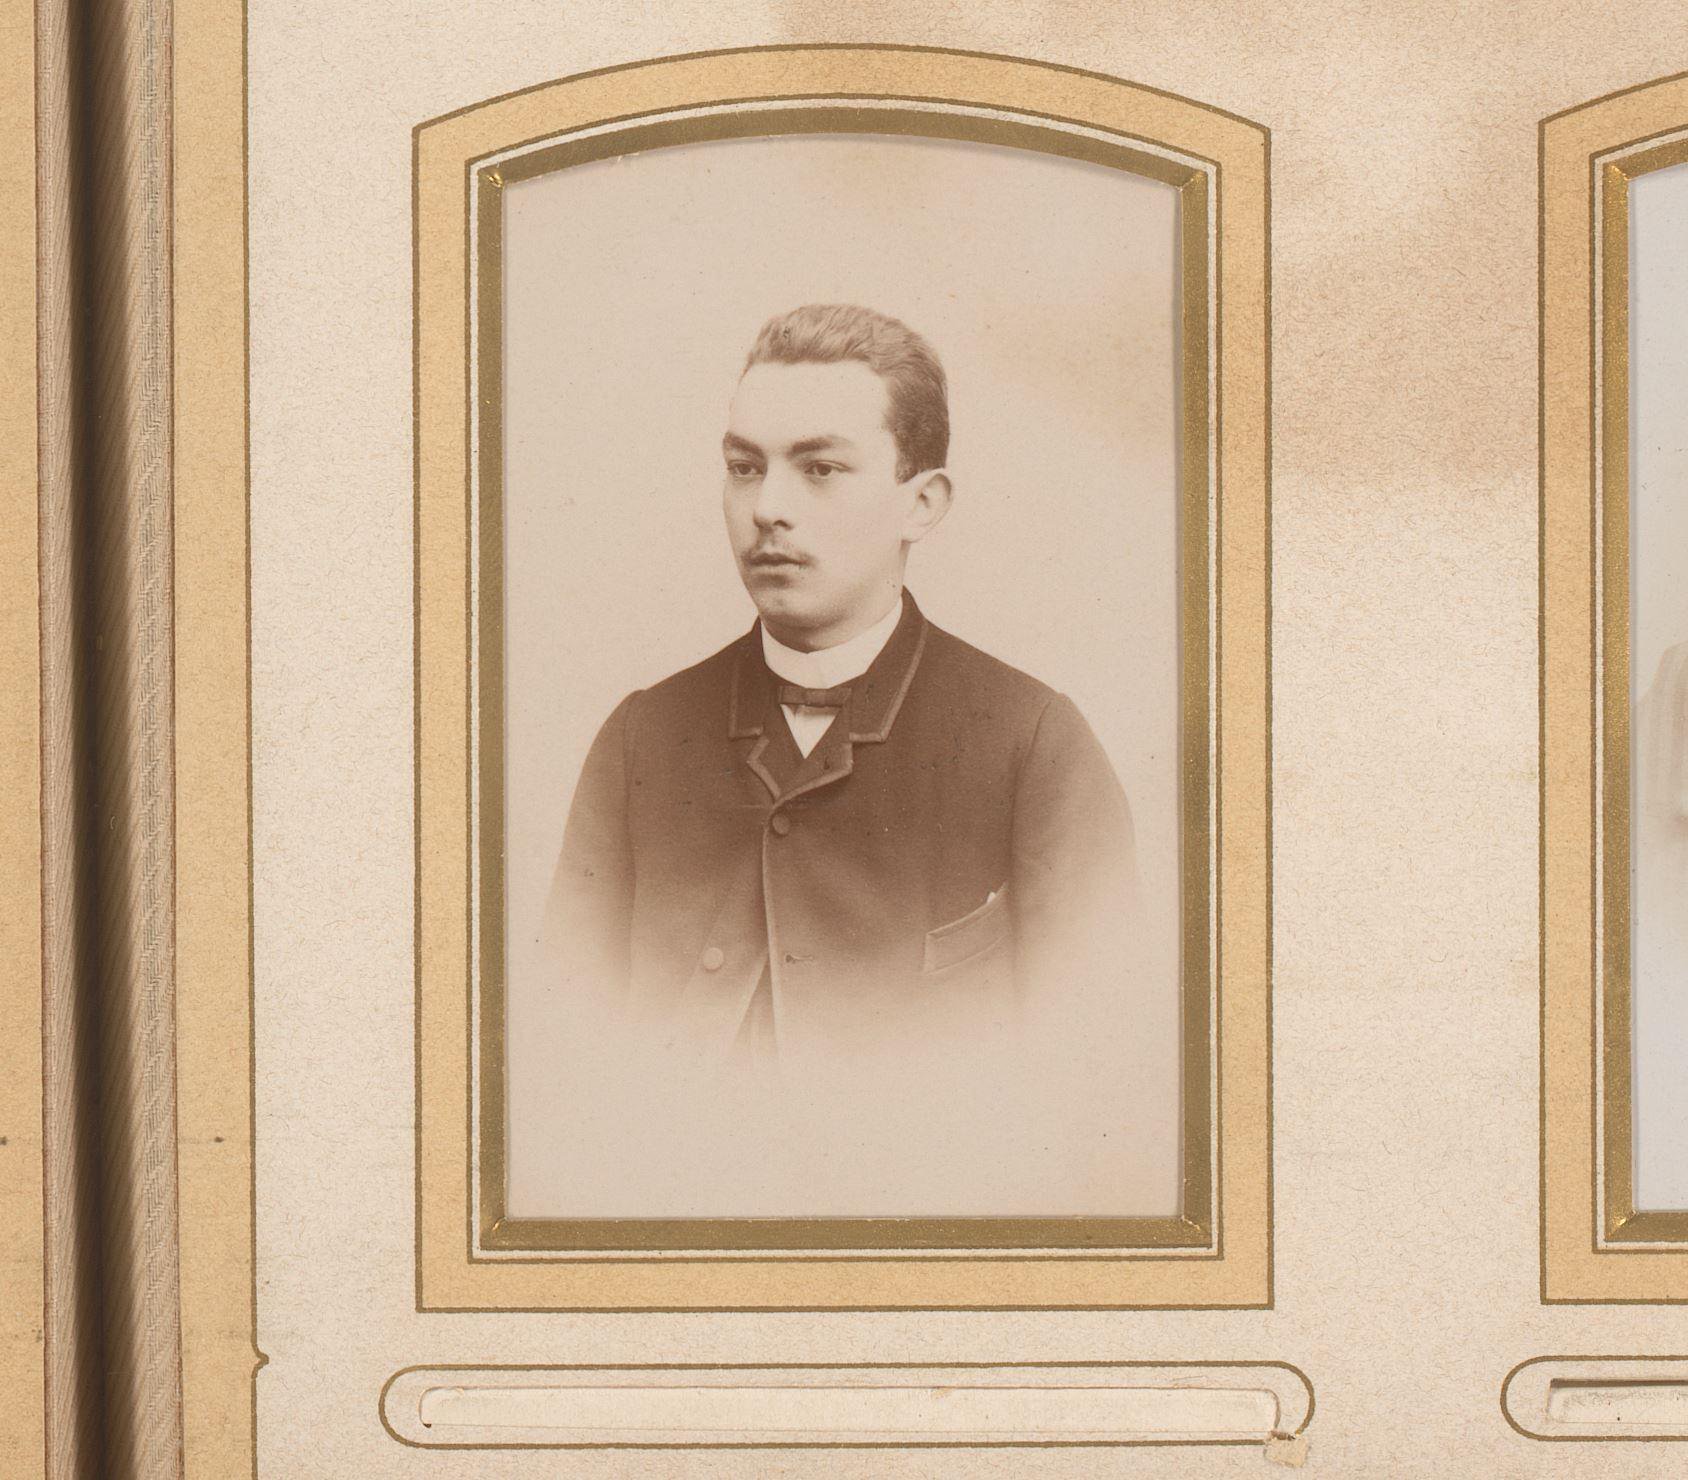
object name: photograph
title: Portret van een man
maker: Anonymous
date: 1870-1900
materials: cardboard, photographic support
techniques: albumen print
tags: adult man, historical persons